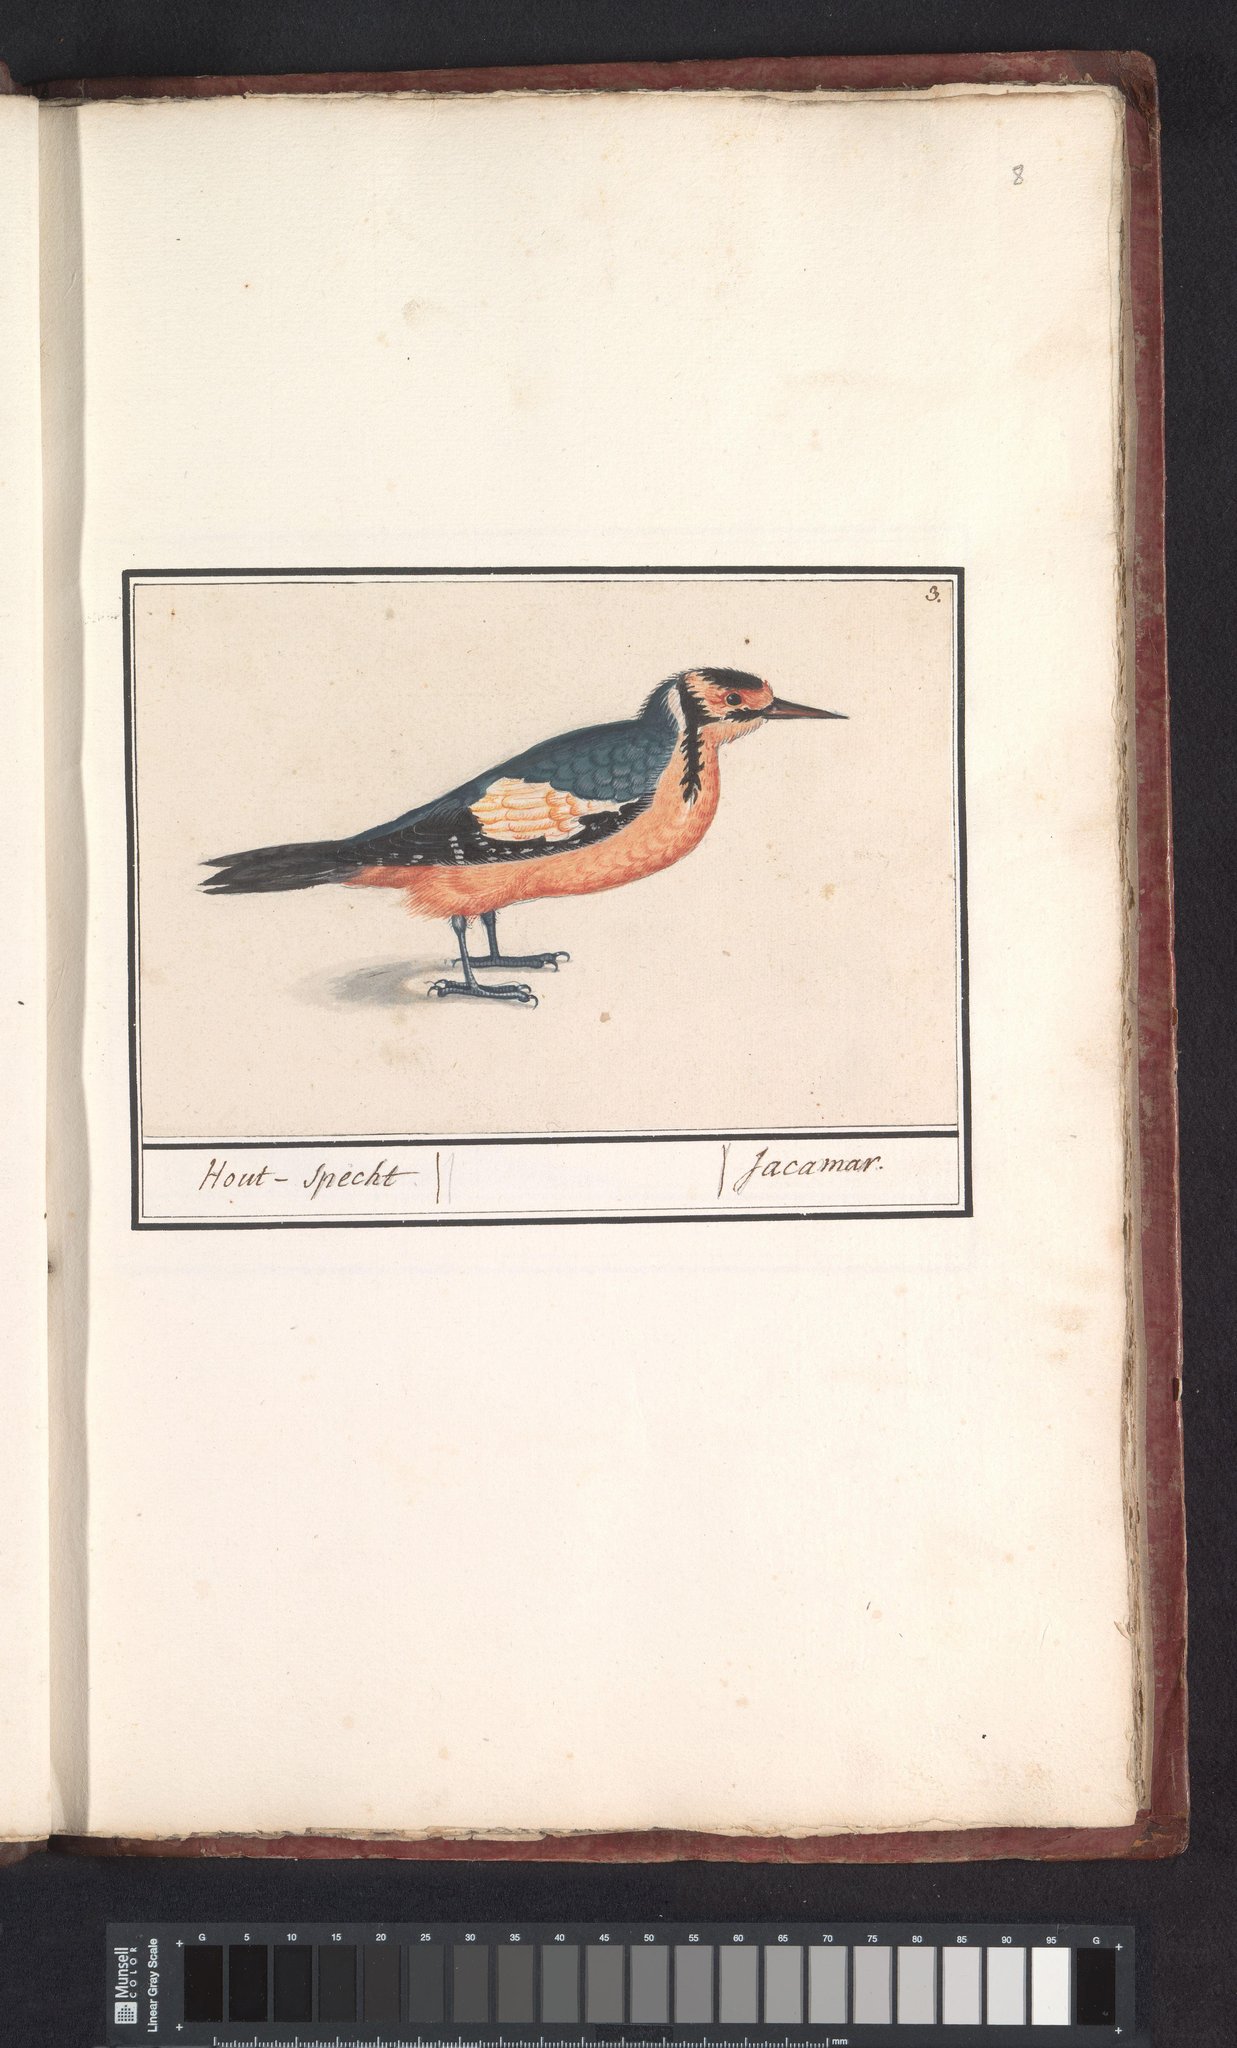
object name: drawing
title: Grote bonte specht (Dendrocopos major)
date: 1596-1610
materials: paint, paper, pencil, watercolor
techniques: brush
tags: other birds: woodpecker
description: Grote bonte specht. Genummerd rechtsboven: 3. Onderdeel van het derde album met tekeningen van vogels. Vijfde van twaalf albums met tekeningen van dieren, vogels en planten bekend rond 1600, gemaakt in opdracht van keizer Rudolf II. Met toelichting in Nederlands, Latijn en Frans.